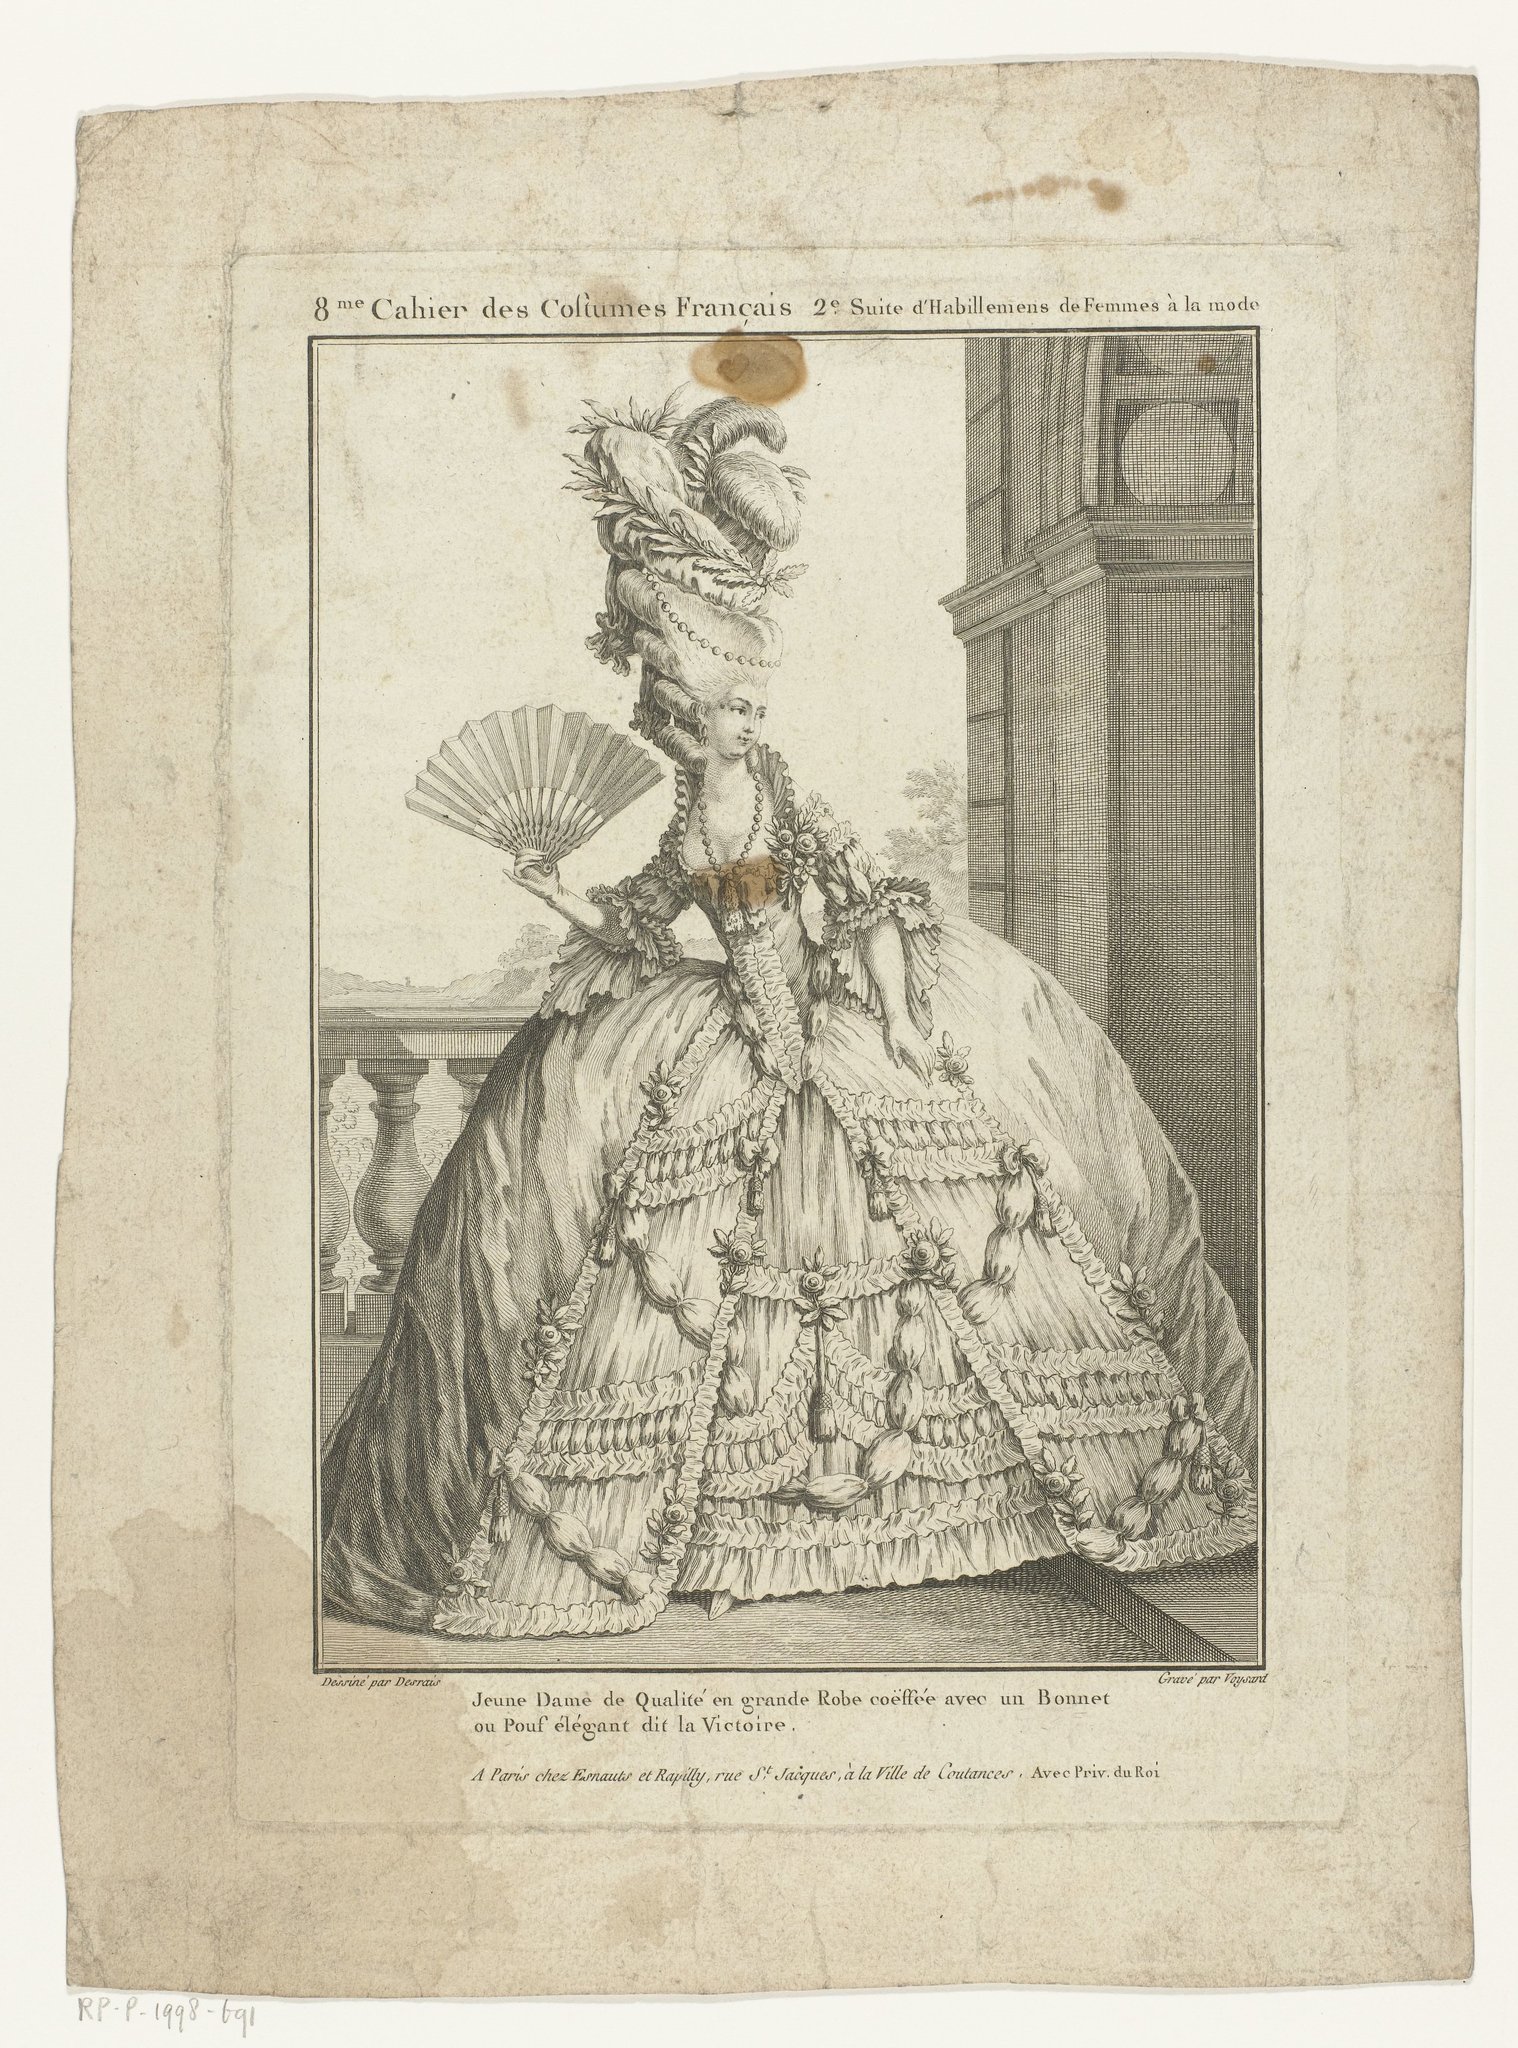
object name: costume print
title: Gallerie des Modes et Costumes Francais, 1778, H.43: Jeune Dame de Qualité en grande Robe...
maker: etienne claude voysard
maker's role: print maker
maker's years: 1746-1812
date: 1770-1810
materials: paper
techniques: engraving, etching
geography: france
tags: ornamental parts of clothing (+ women's clothes), head-gear (pouf) (+ women's clothes), styles of hairdress - aa - ~ women, fashion plates, dress, gown (+ women's clothes)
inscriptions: caption: ‘Jeune Dame de Qualité en grande Robe coëffée avec un Bonnet ou Pouf élégant dit la Victoire’, signature: ‘Dessiné par Desrais.’, address: ‘A Paris chez Esnauts et Rapilly, rue St. Jacques...’, signature: ‘Gravé par Voysard’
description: Jonge vrouw van stand, ten voeten uit, in hofjapon met brede paniers. Op het hoge kapsel een elegante 'Bonnet' of 'Pouf' die 'la Victoire' werd genoemd. Open vouwwaaier in de hand. Prent uit 8me Cahier des Costumes Francais, 2e Suite d'Habillemens de Femmes à la mode (ca. 1790).